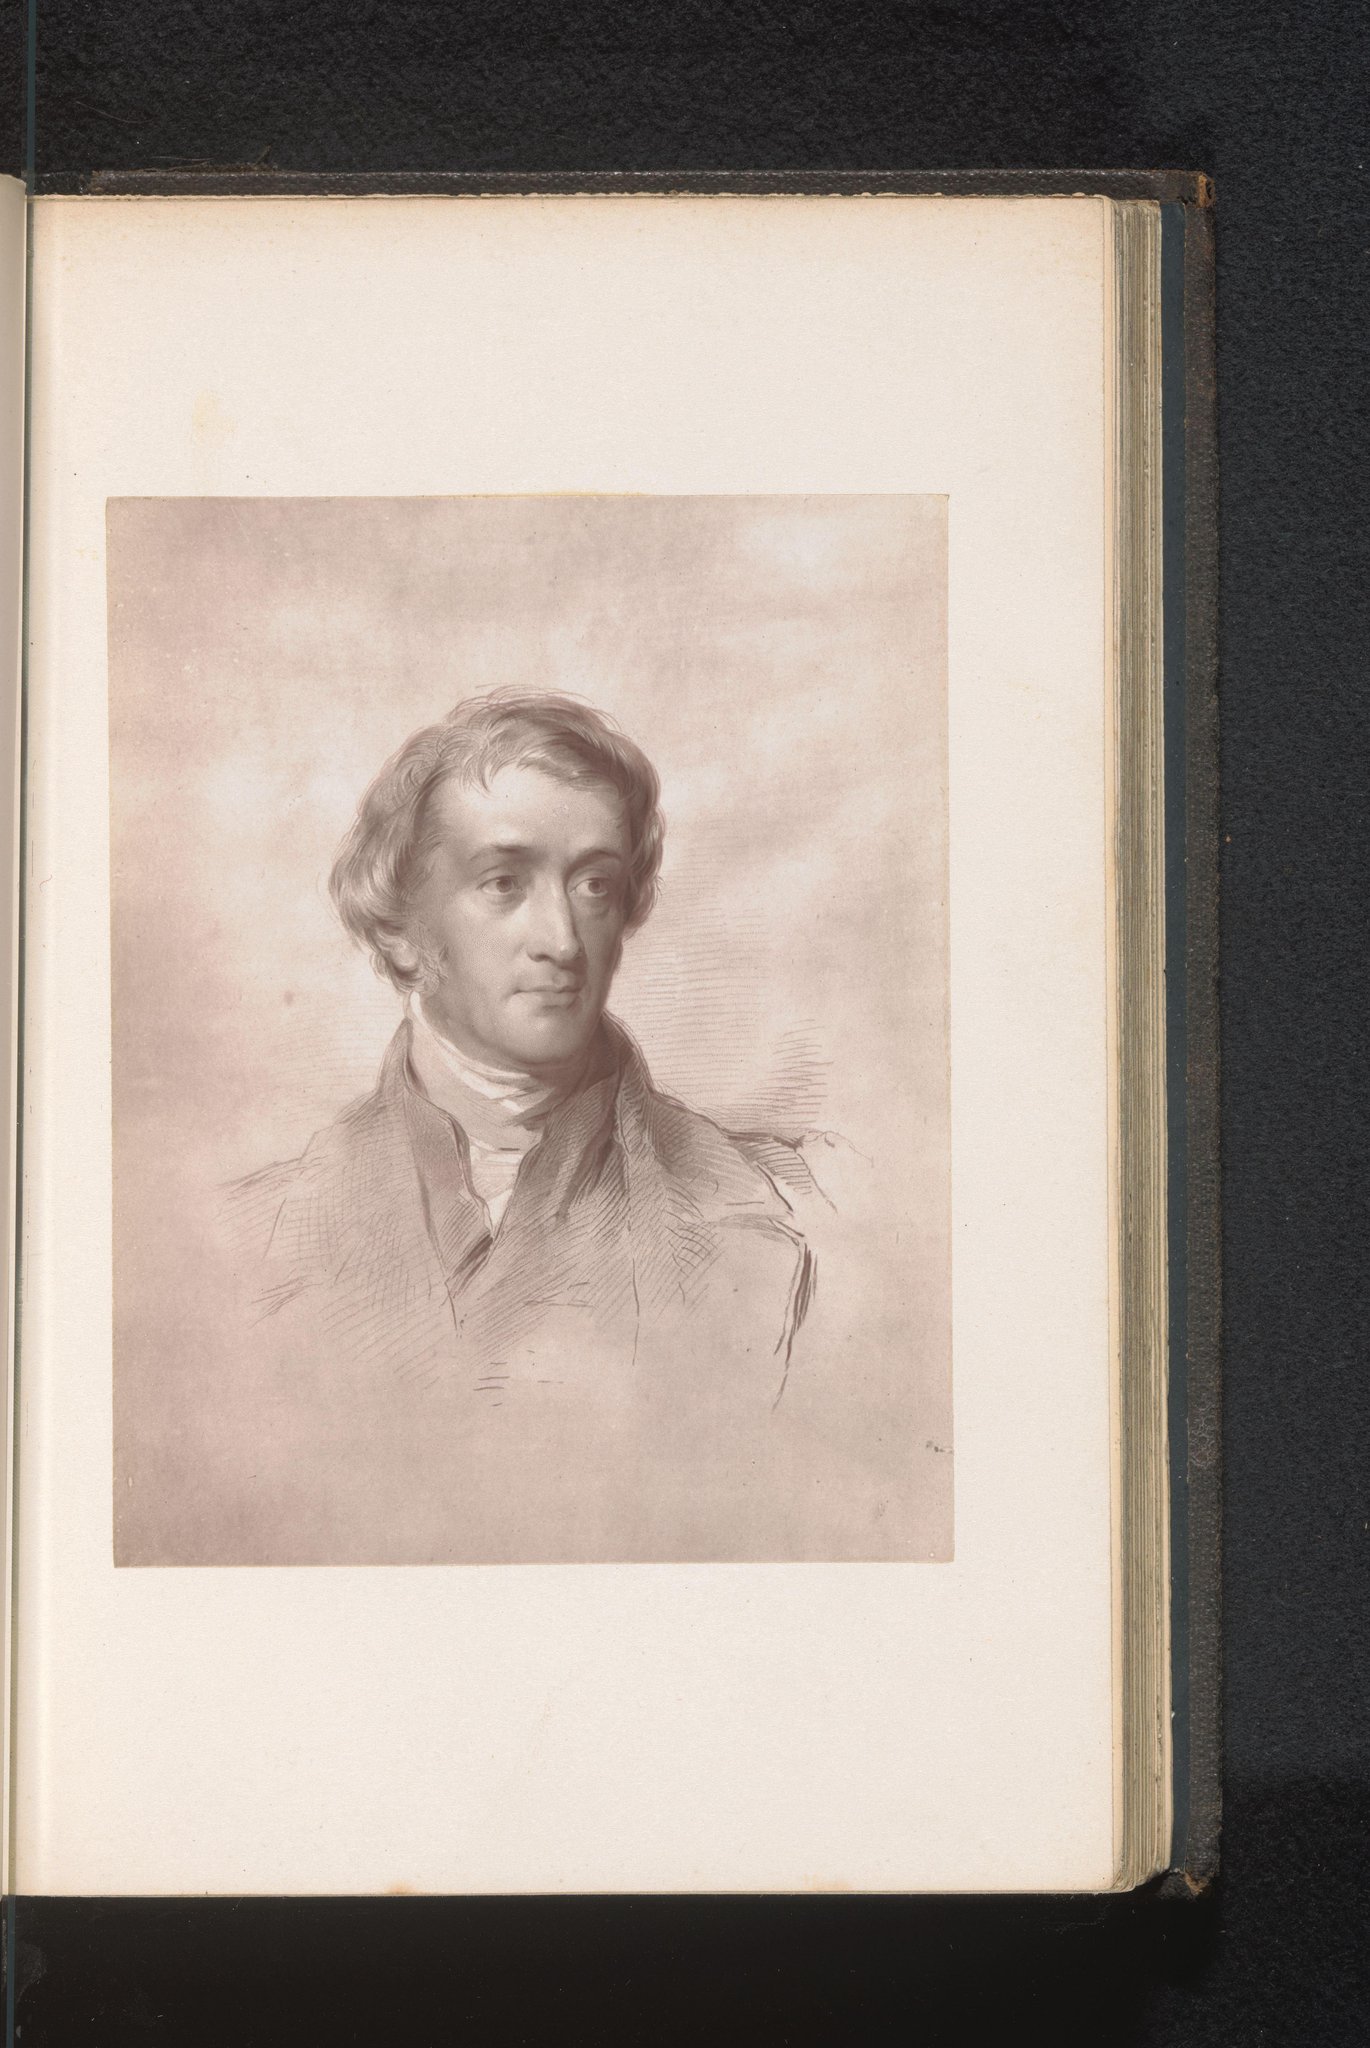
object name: reproduction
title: Fotoreproductie van een tekening, voorstellende een portret van Julius Charles Hare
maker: Anonymous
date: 1866-1876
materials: paper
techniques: woodburytype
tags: historical persons